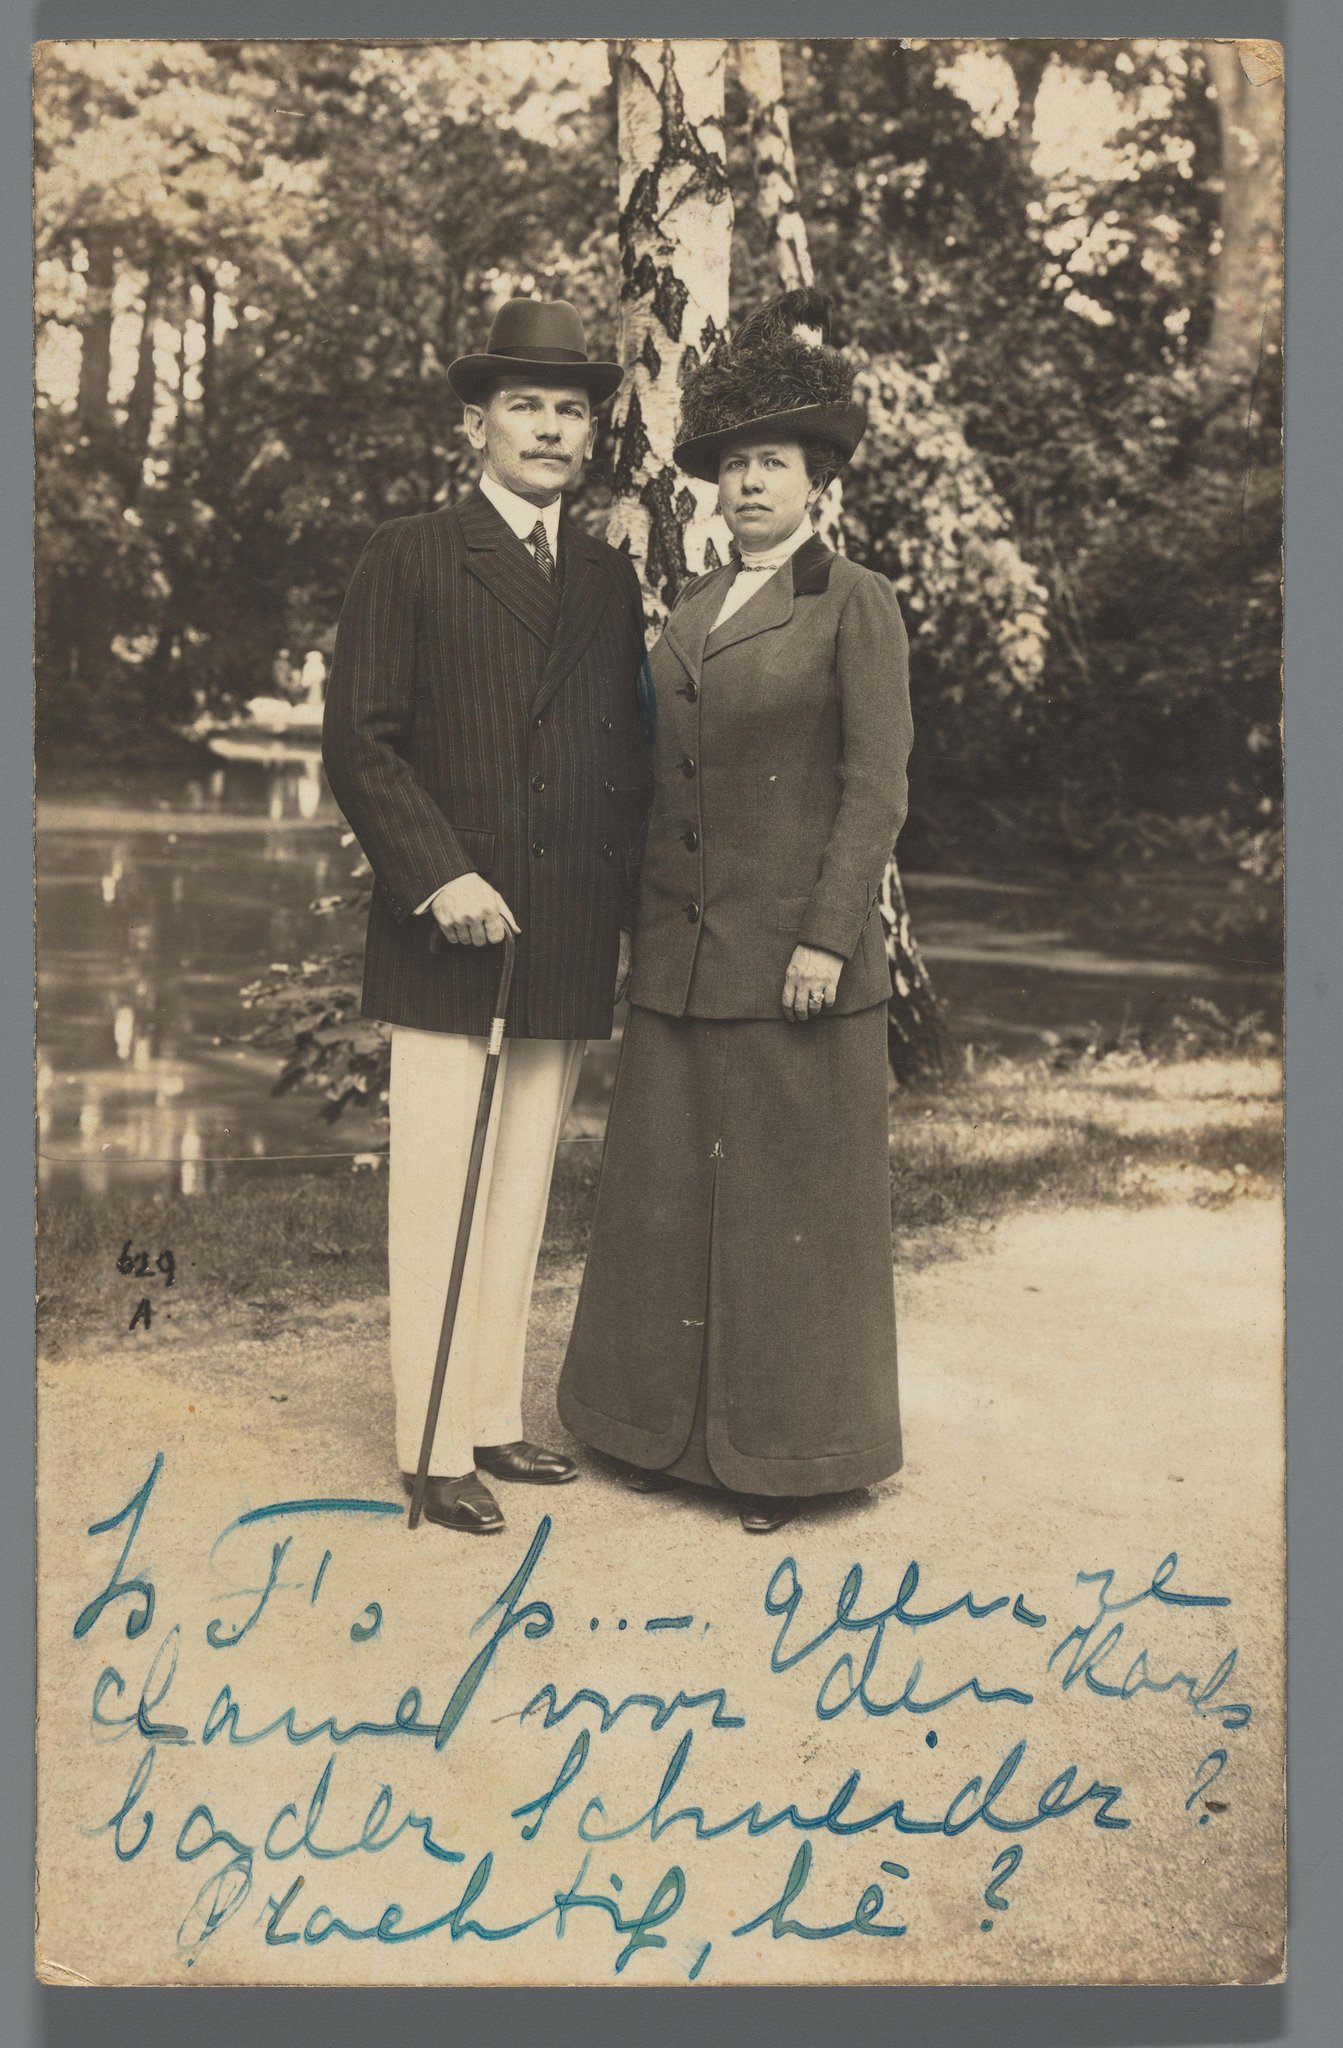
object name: photograph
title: Frans Alexander van den Berg en Poppy Dunlop in een park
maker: Anonymous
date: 1900-1912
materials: photographic support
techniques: photography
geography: bad nauheim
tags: amsterdam, frans alexander van den berg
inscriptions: stamp: ‘BAD NAUHEIM / 14.712 5.6 N’, inscription, inscription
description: Uit Bad Nauheim naar Arnhem verzonden briefkaart met rood postzegel.